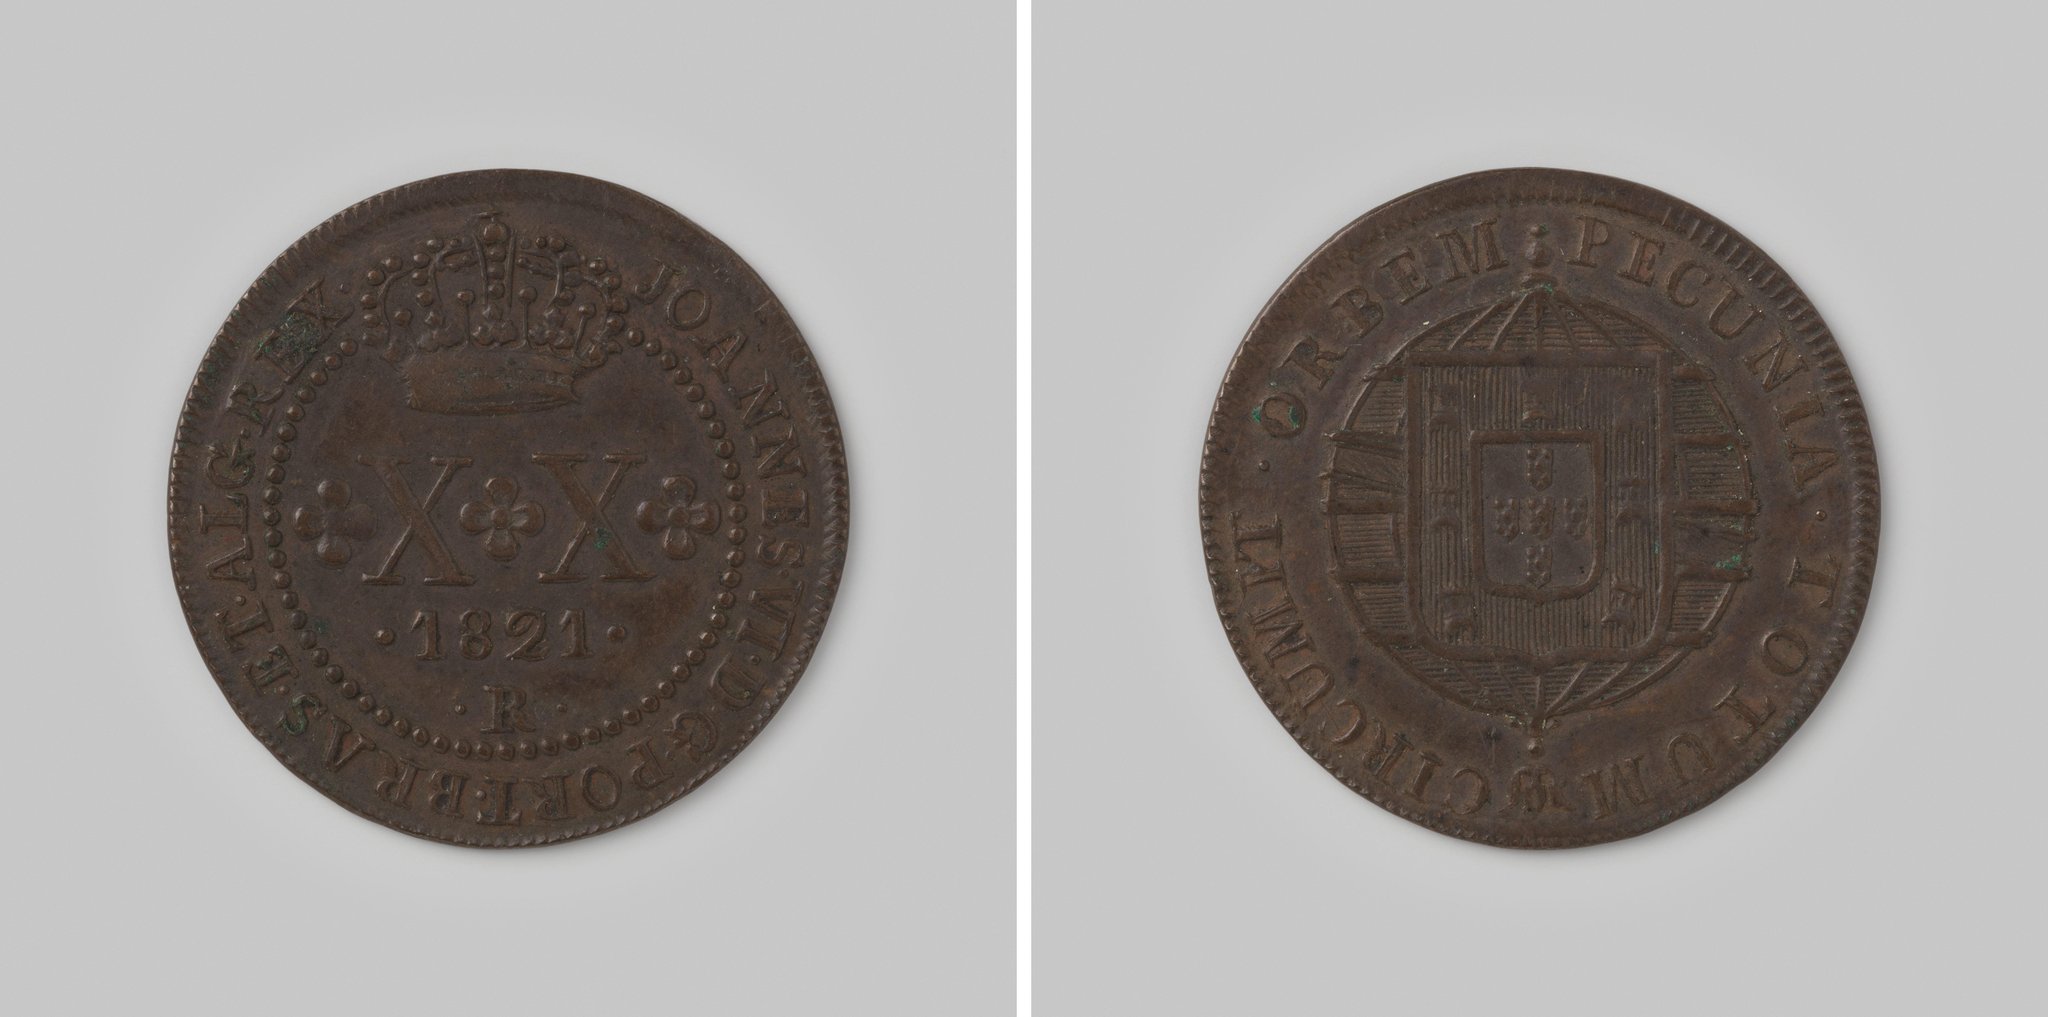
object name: coin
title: Vintem of 20 reis van Brazilië van prins-regent Joao VI, 1821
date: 1821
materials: copper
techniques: striking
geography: rio de janeiro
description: Koperen munt. Voorzijde: onder kroon waarde-aanduiding: XX. Daaronder jaartal, waaronder letter R [=Rio]. Keerzijde: wapenschild van Portugal op wereldbol, waaromheen lint, rondom verticale as op voetstuk. Gladde rand.